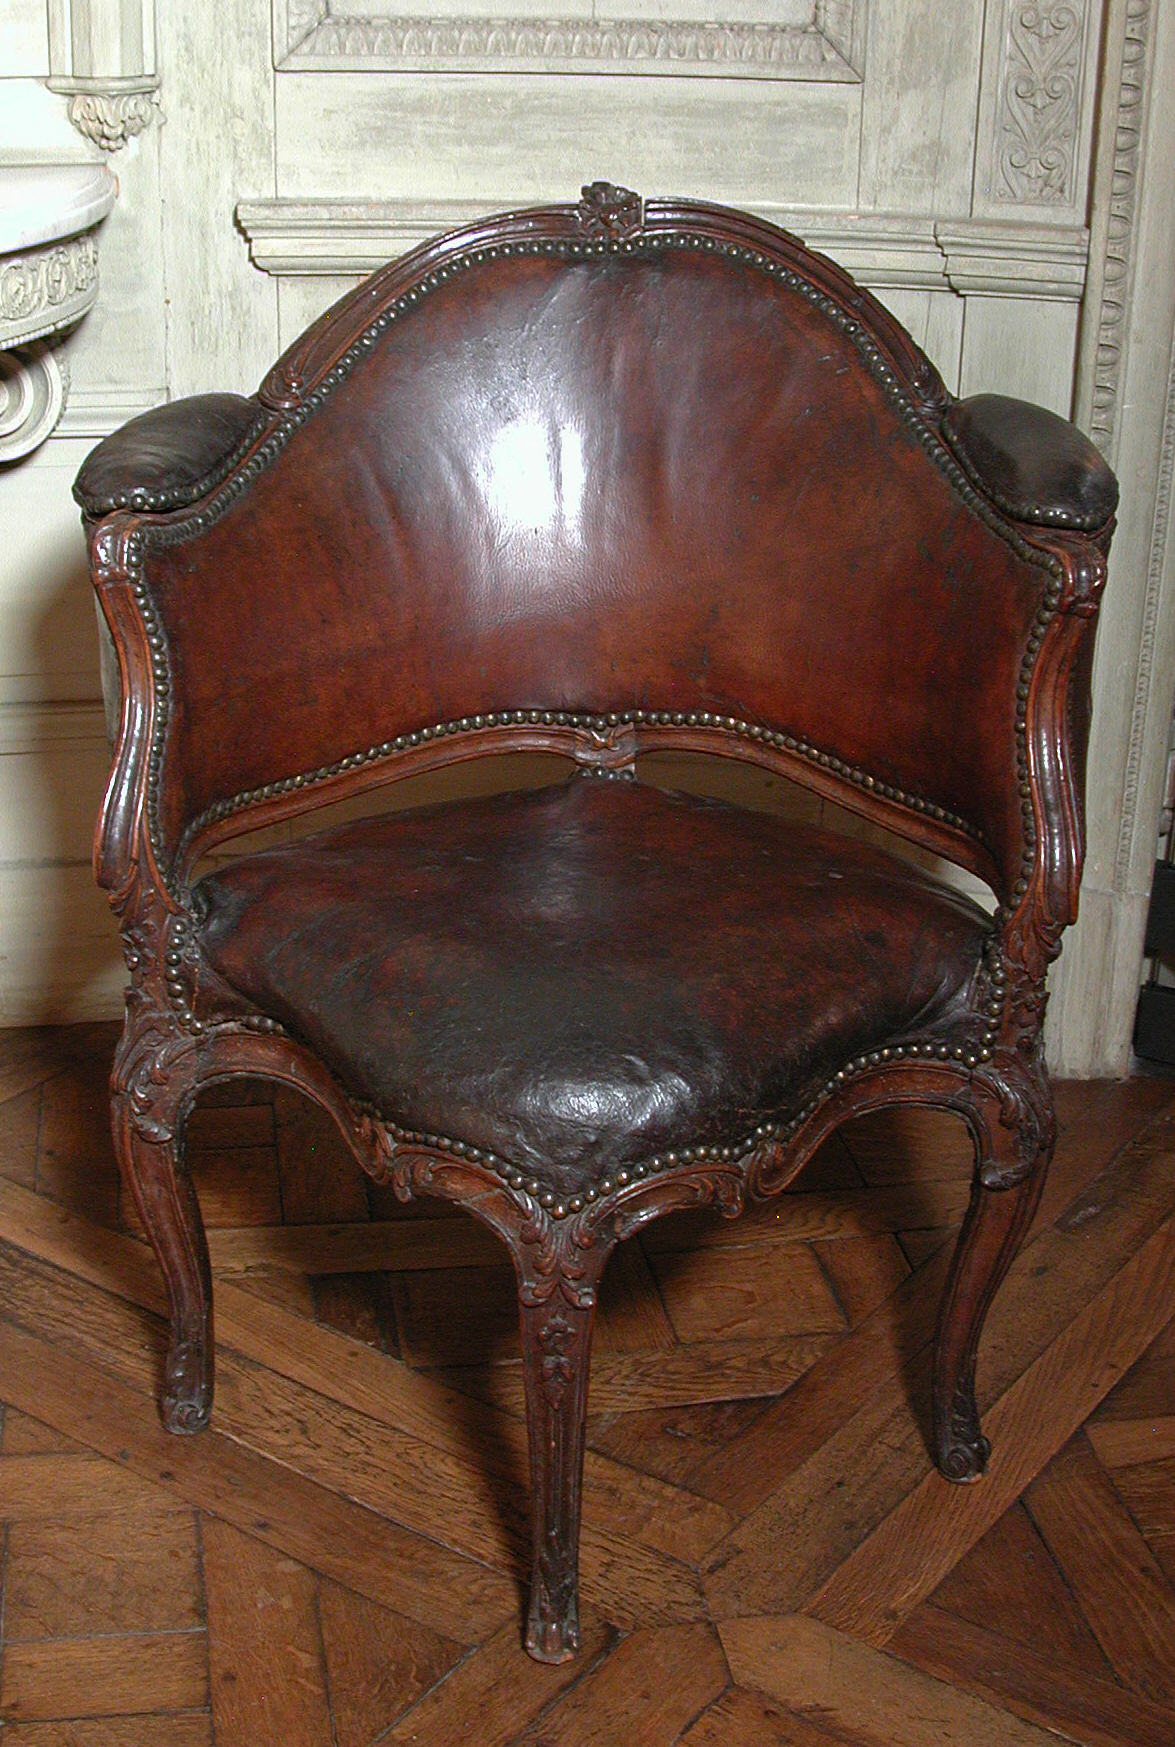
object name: desk chair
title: Desk chair (Fauteuil de bureau)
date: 1750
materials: brass, leather, wood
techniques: carving